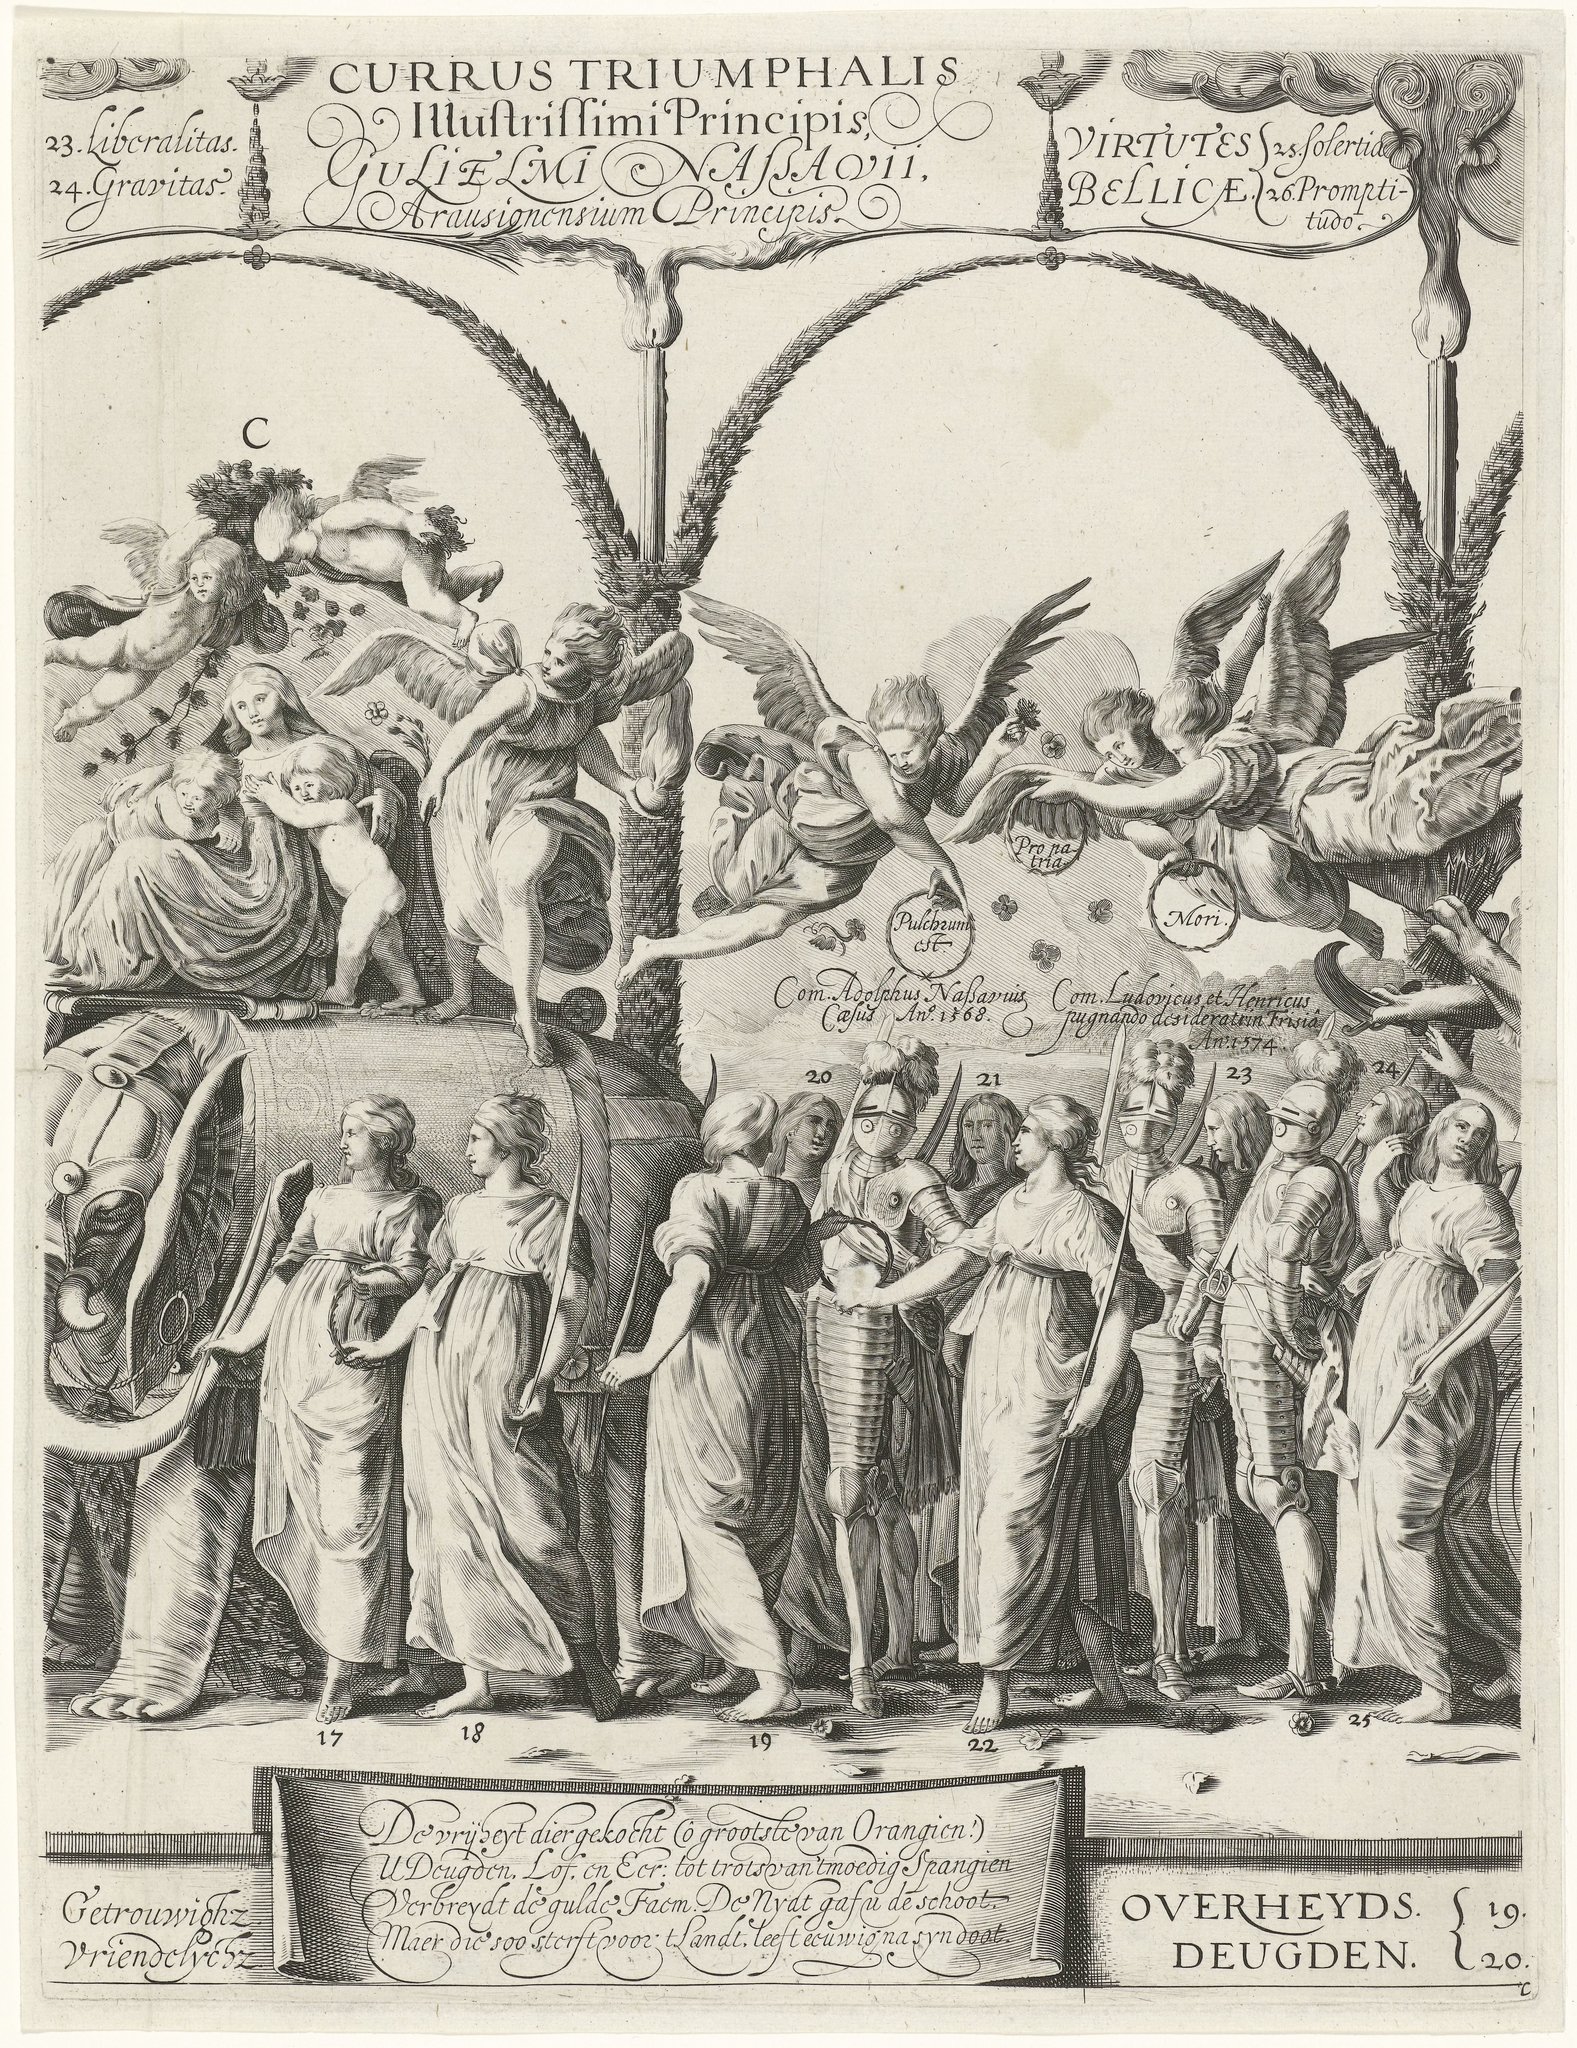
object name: propagandaprent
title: Currus triumphalis Illustris / Triomftocht van Willem van Oranje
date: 1623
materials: paper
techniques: engraving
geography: haarlem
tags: delft, william i (prince of orange), charity, 'caritas'; 'carità' (ripa) ~ one of the three theological virtues, symbolic triumphs of individual persons, trunked animals: elephant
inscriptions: collector's mark: Lugt 240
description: Zinnebeeldige voorstelling van de deugden van Prins Willem van Oranje. Zegewagen waarin de prins zit, rijdt onder een erepoort van loofwerk door, getrokken door 3 olifanten. Op de olifant de personificatie Liefde; naast hen andere personificaties van deugden. Met uitleg in het Latijn boven de figuren, Hollandse vertaling onderaan.